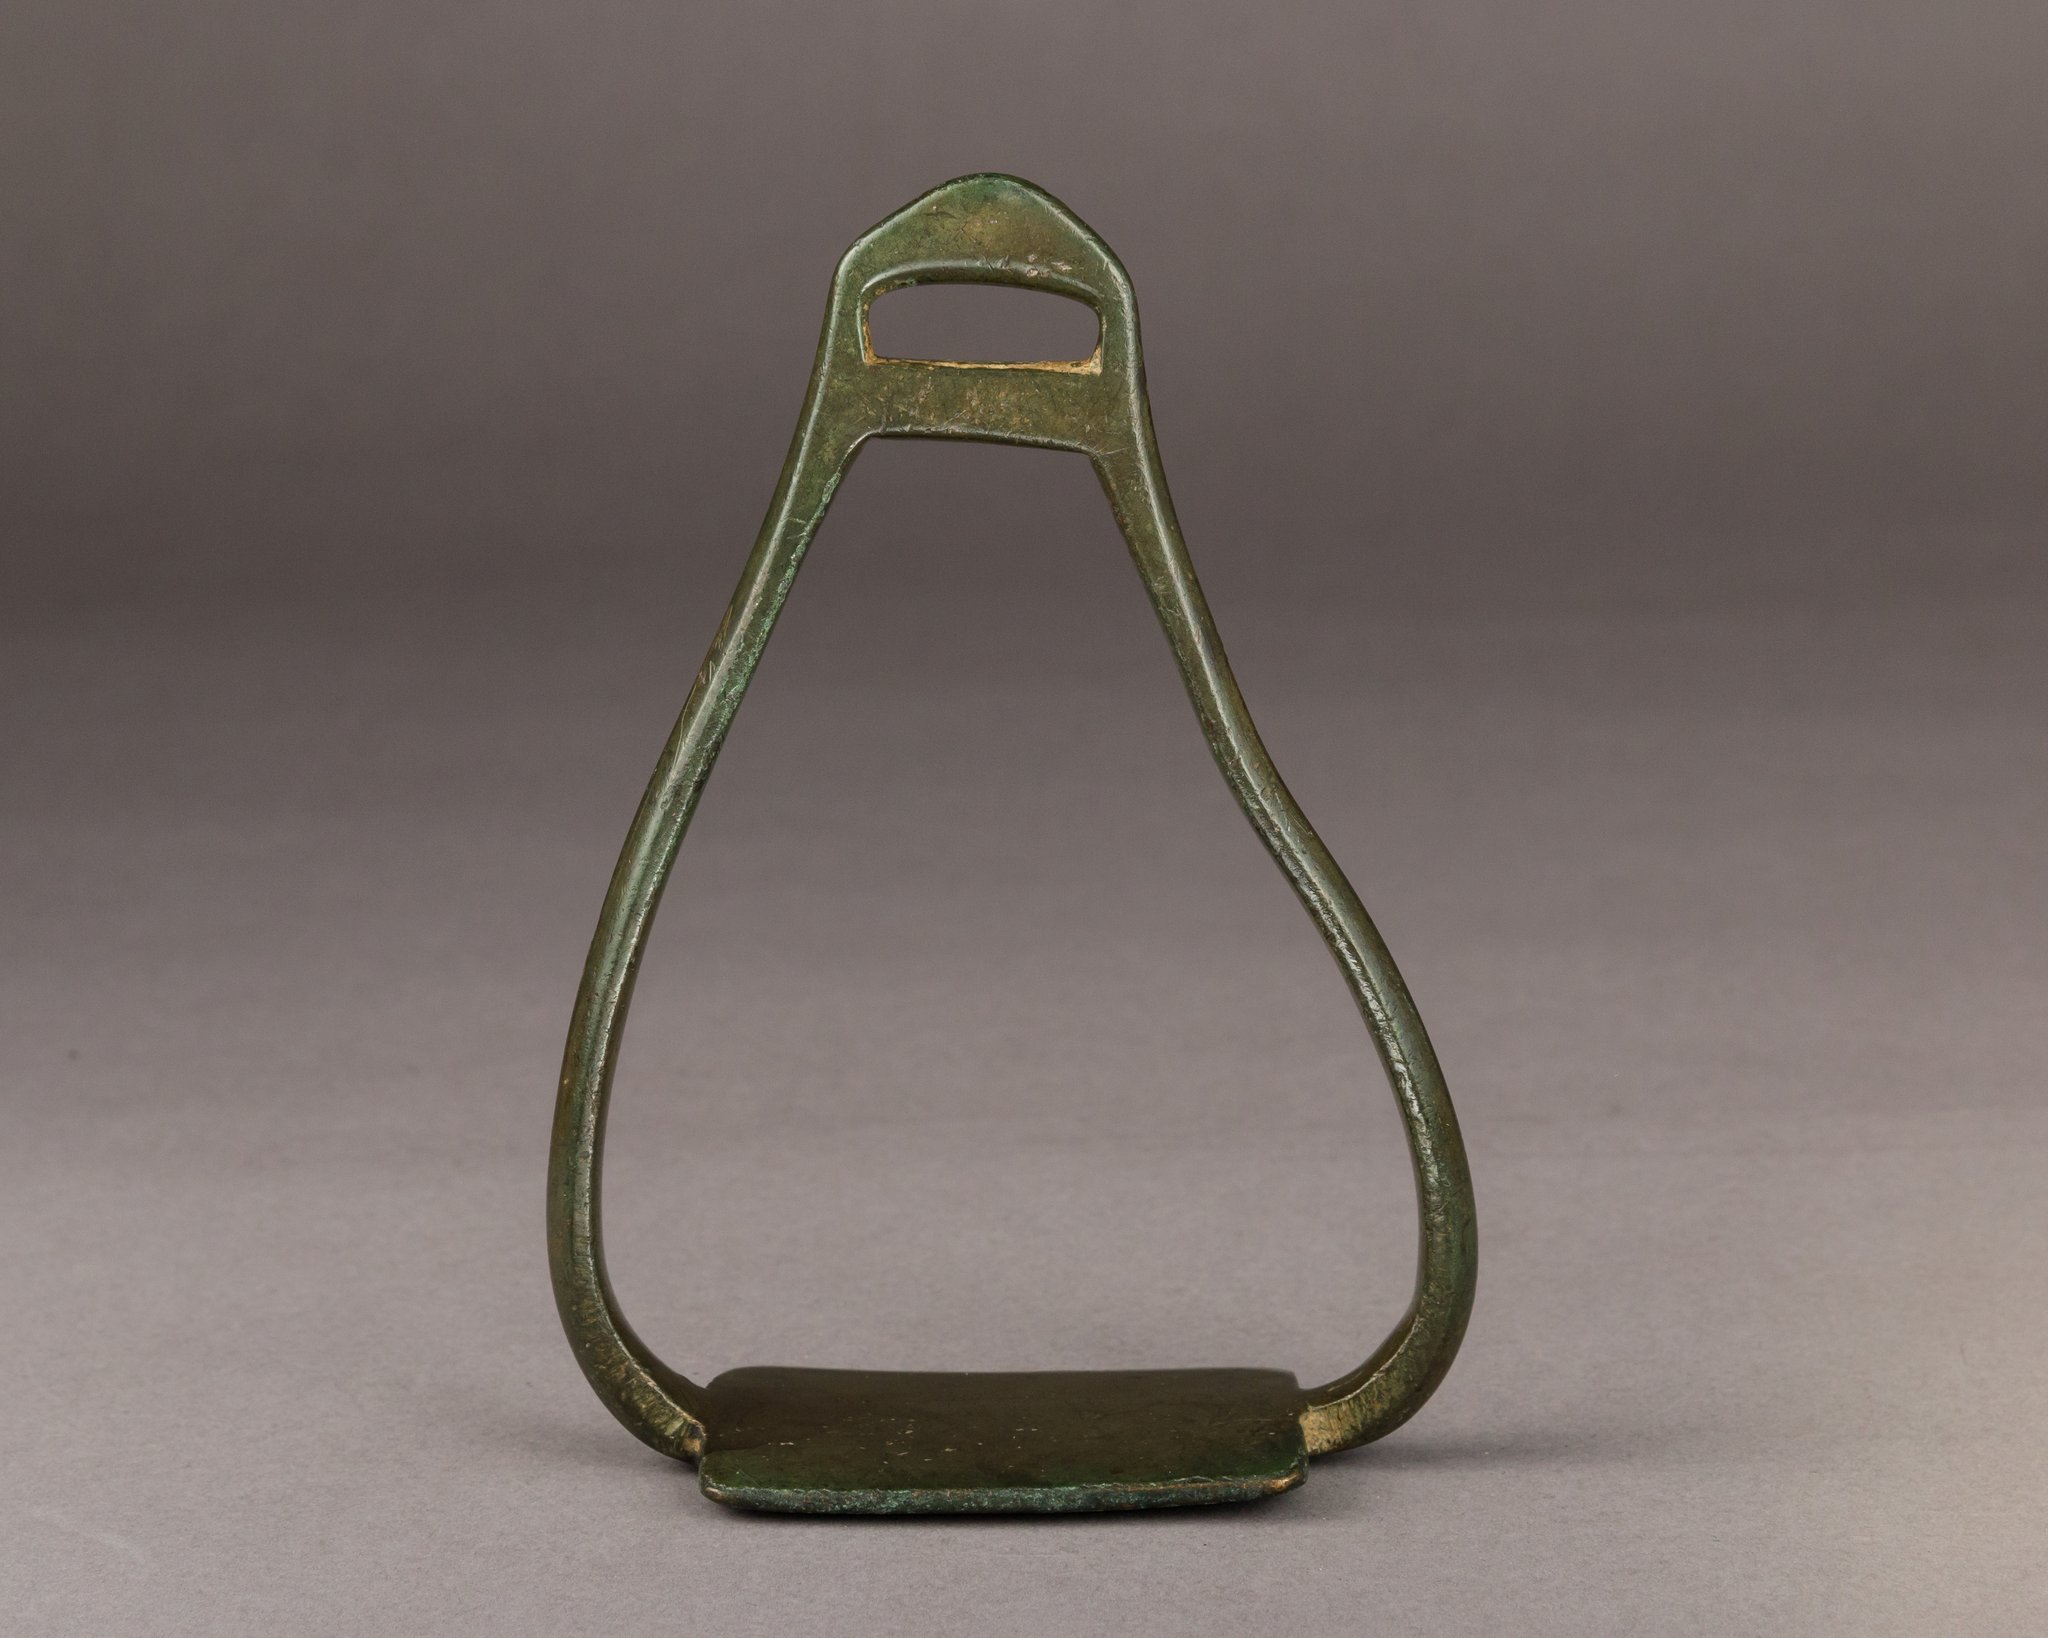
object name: stirrup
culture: east european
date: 1401-1700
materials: copper alloy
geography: possibly balkans